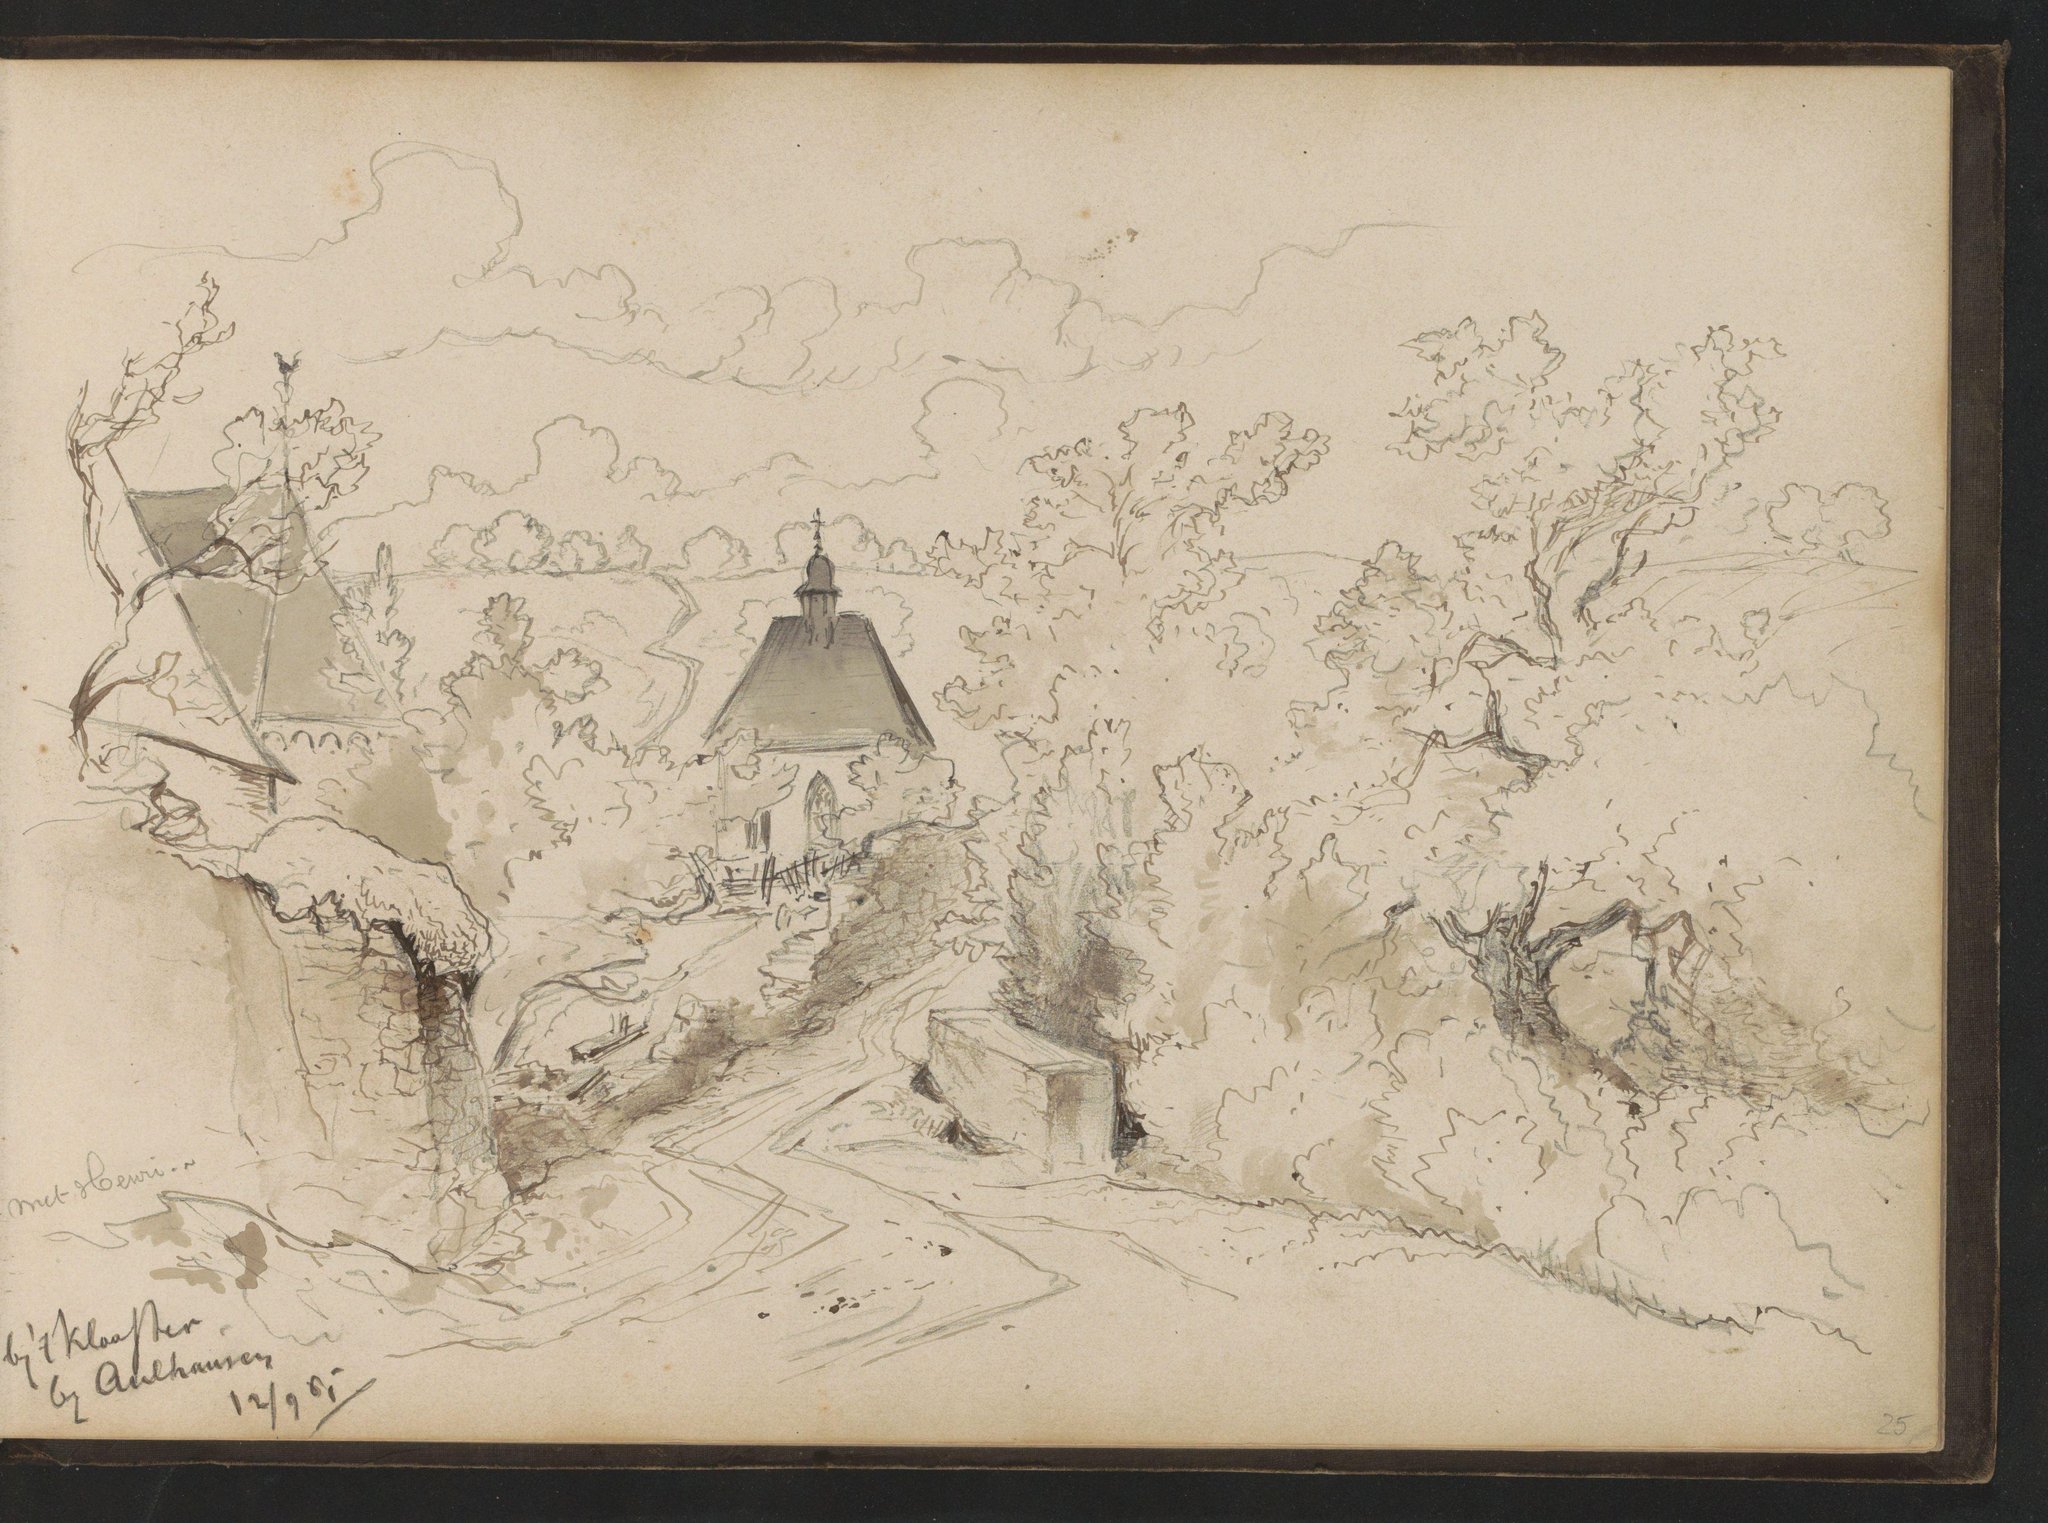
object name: sketchbook leaf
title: Weg bij het klooster bij Aulhausen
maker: johannes tavenraat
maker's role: draughtsman, painter, print maker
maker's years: 1809-1881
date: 1809-1861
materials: ink, paper, pencil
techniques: brush, pen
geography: rüdesheim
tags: city-view, and landscape with man-made constructions, road, path, cloisters ~ monastery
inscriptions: date and inscription: ‘met Henri/ bij 't klooster/ bij Aulhausen/ 12/9 61’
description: Blad 25 recto uit een schetsboek met 57 bladen.